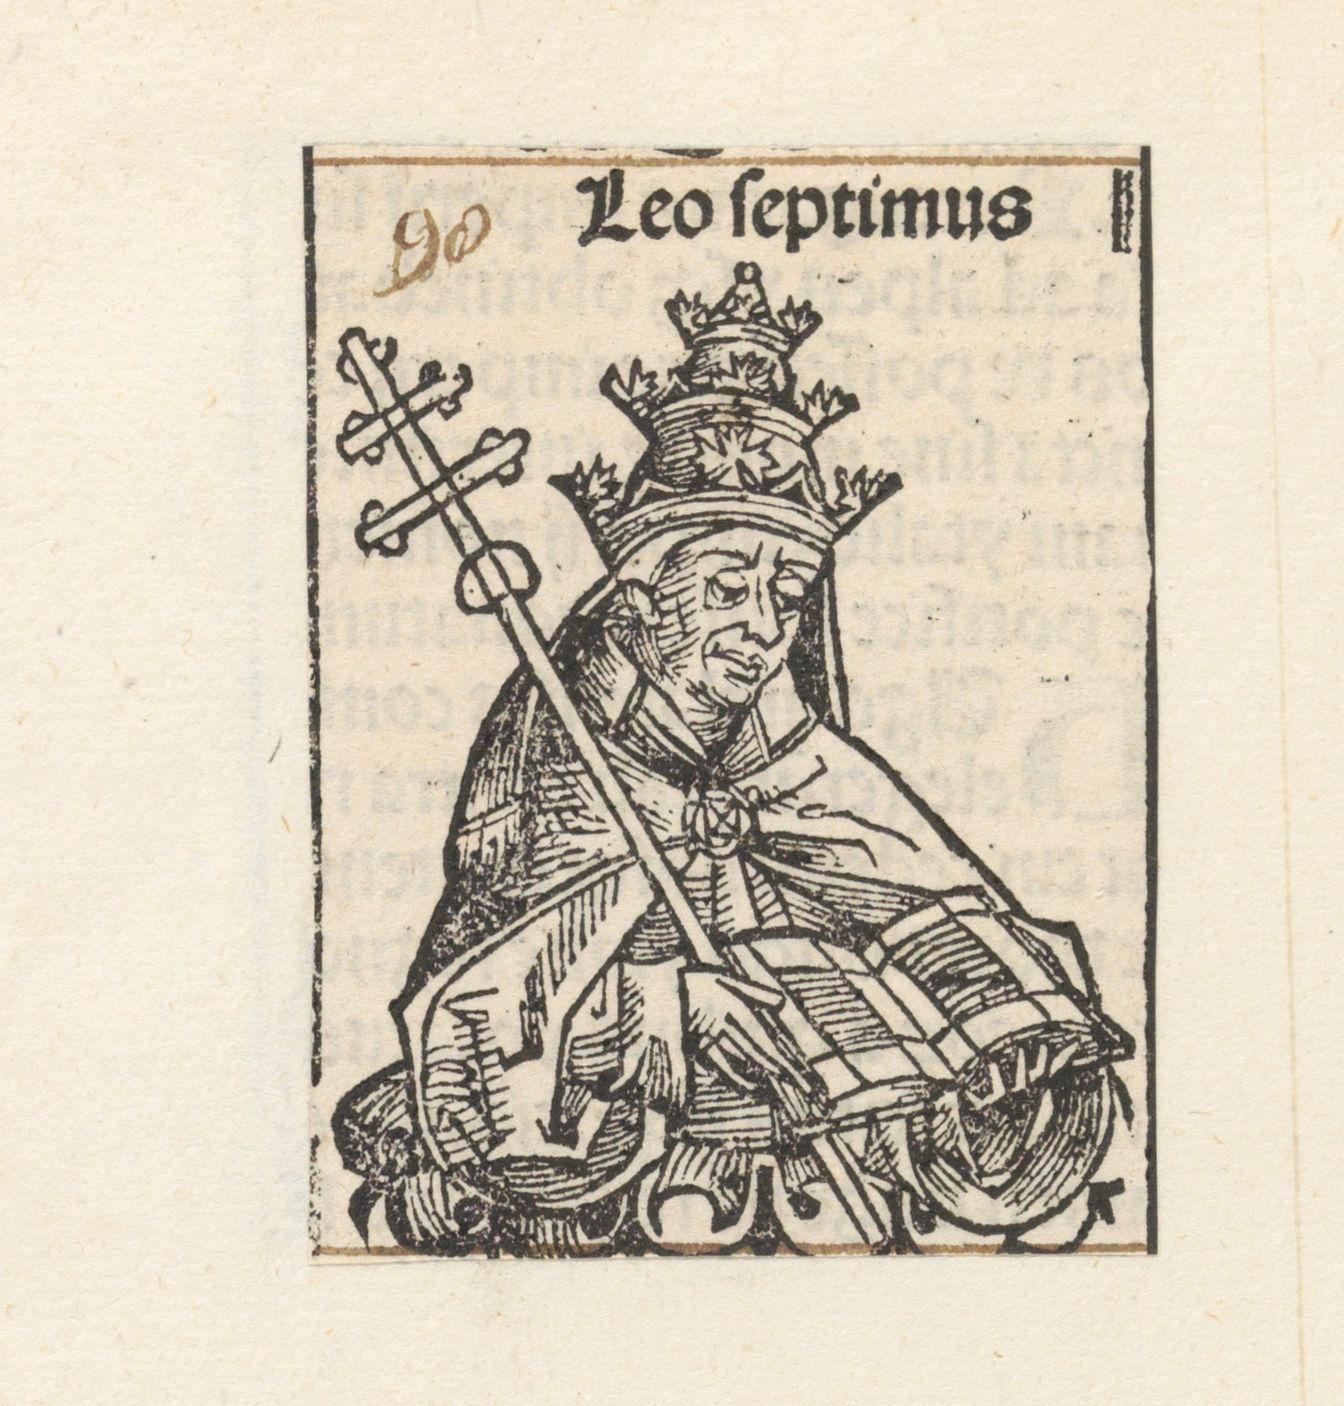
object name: print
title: Liber Chronicarum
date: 1493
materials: paper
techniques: letterpress printing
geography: nuremberg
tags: pope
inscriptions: inscription: ‘98’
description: Een bloemkelk met een paus. Hij draagt een tiara en heeft een opengeslagen boek en een staf met een dubbel kruis in zijn handen. De voorstelling is onderdeel van de opeenvolging pausen in de Liber Chronicarum. De tekst identificeert de man als Leo VII. De prent maakt deel uit van een album.